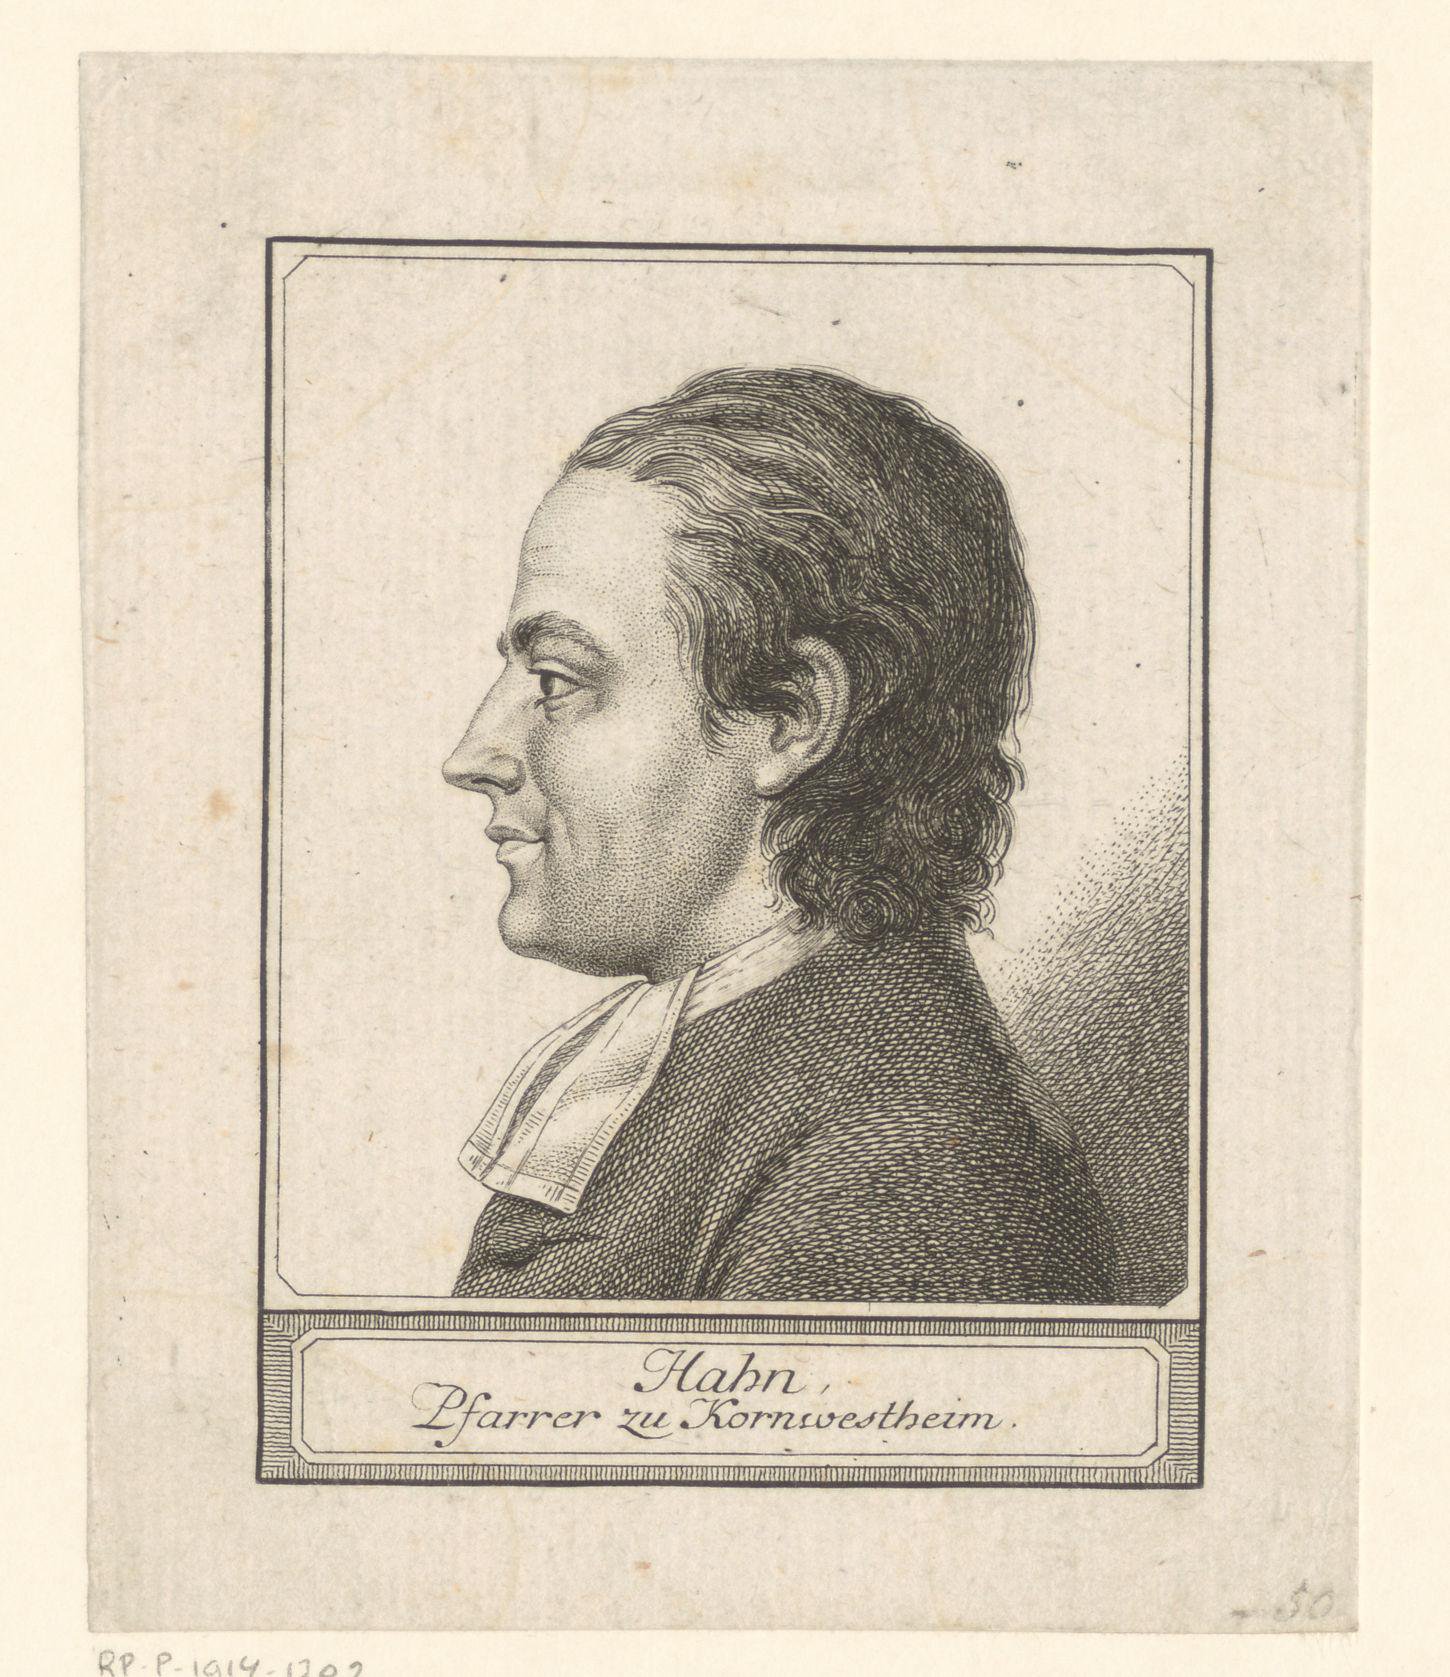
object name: print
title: Portret van Philipp Matthäus Hahn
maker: Anonymous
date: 1780-1800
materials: paper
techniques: etching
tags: engineer, historical persons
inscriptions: collector's mark: Lugt 2228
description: Niet te verwarren met het portret van Philipp Matthäus Hahn door Daniel Berger, beschreven in: Rost, Carl Christian Heinrich. Anzeige sämmtlicher Werke von Herrn Daniel Berger(...). Leipzig: Rostischen Kunsthandlung, 1792, p. 47, 191.